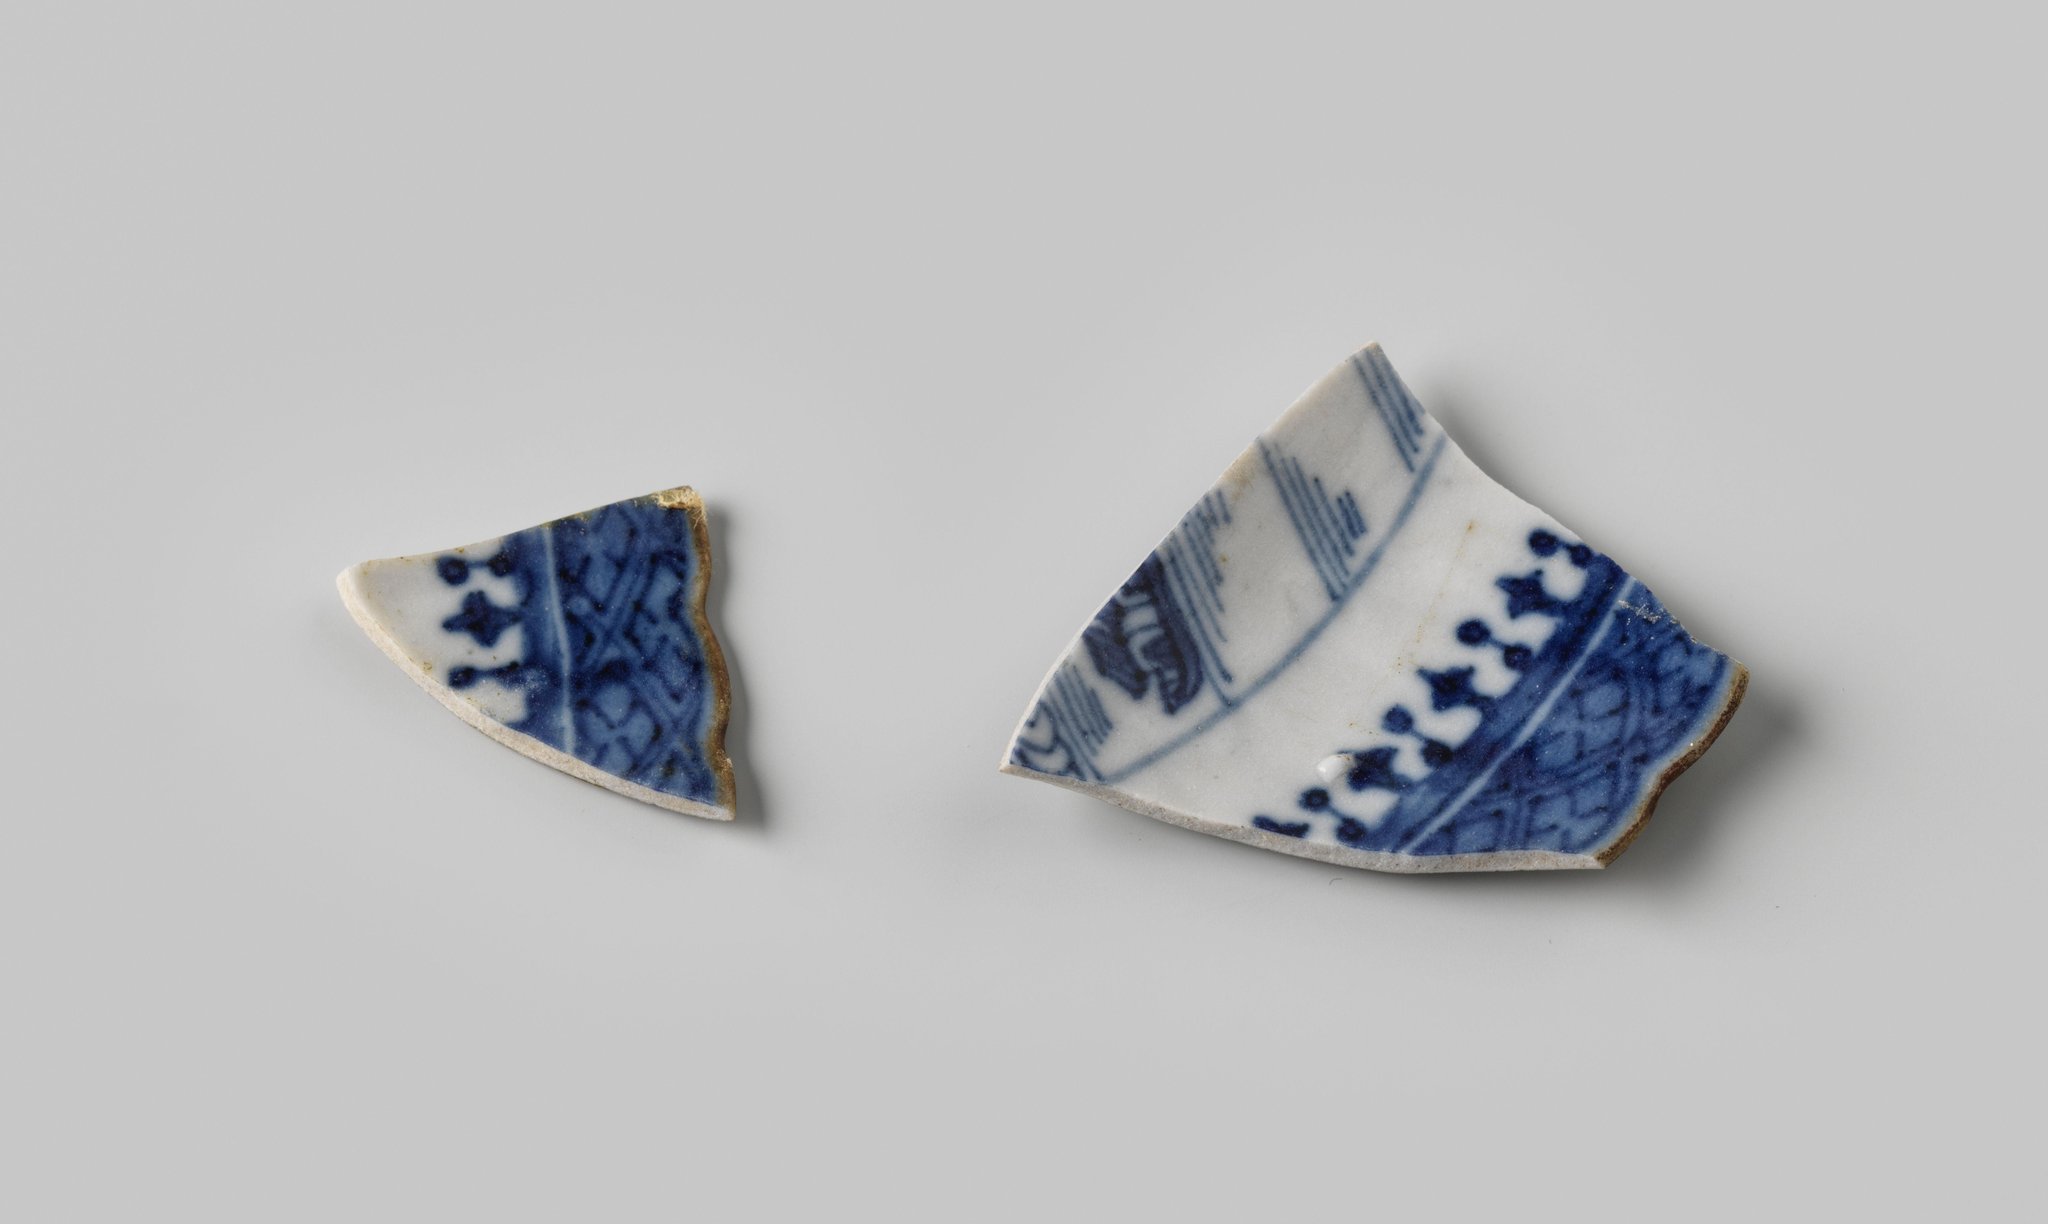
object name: bowl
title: Twee porseleinen scherven, gevonden bij V.O.C.-schip Witte Leeuw, mogelijk afkomstig van Zeelelie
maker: Anonymous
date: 1775-1800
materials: porcelain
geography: jingdezhen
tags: verenigde oostindische compagnie, sint-helena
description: Twee porseleinen scherven van een kom gevonden bij V.O.C.-schip de 'Witte Leeuw'. Dit object is 18e-eeuws en kan dus niet van de vracht van de Witte Leeuw zijn. Onduidelijk is of het object van de site komt of dat het later is vermengd, mogelijk met materiaal van de Zeelelie.